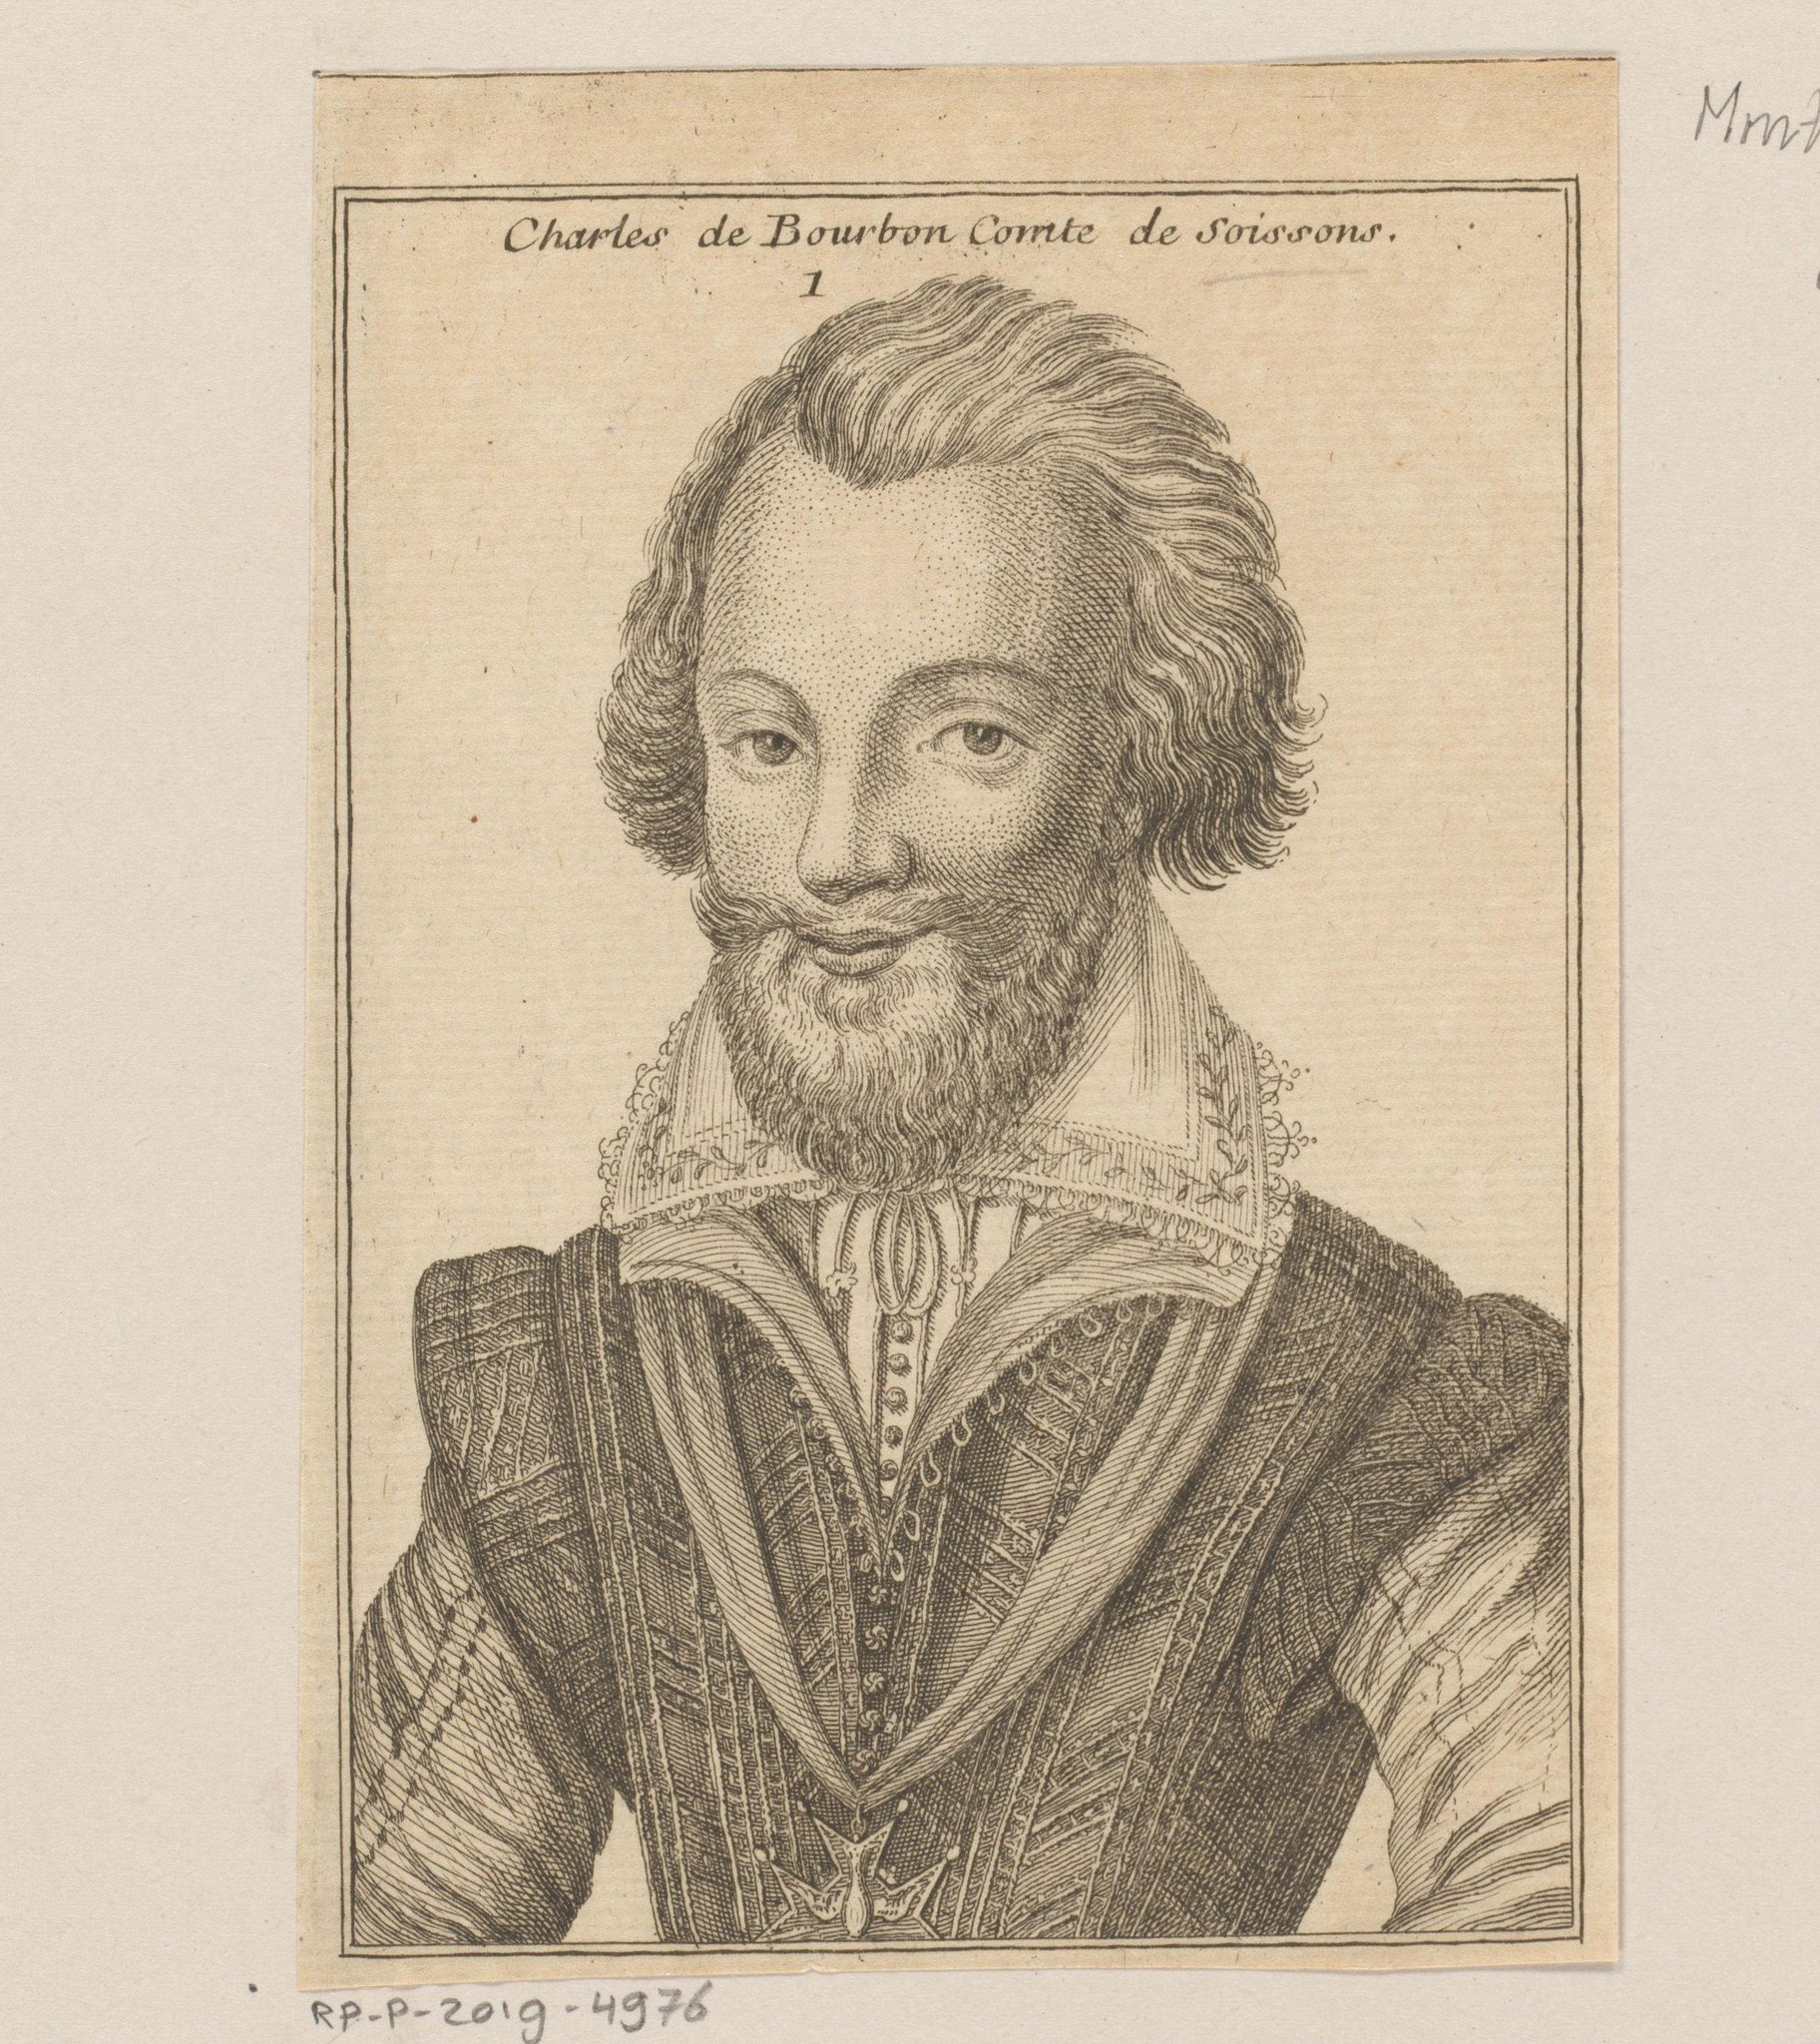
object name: print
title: Portret van Charles de Bourbon, graaf van Soissons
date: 1729-1733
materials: paper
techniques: etching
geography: paris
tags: earl, historical persons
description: Prent uit: Montfaucon, Bernard de. Les monumens de la Monarchie Françoise (...). Parijs: Julien-Michel Gandouin en Pierre-François Giffart, 1729-1733.